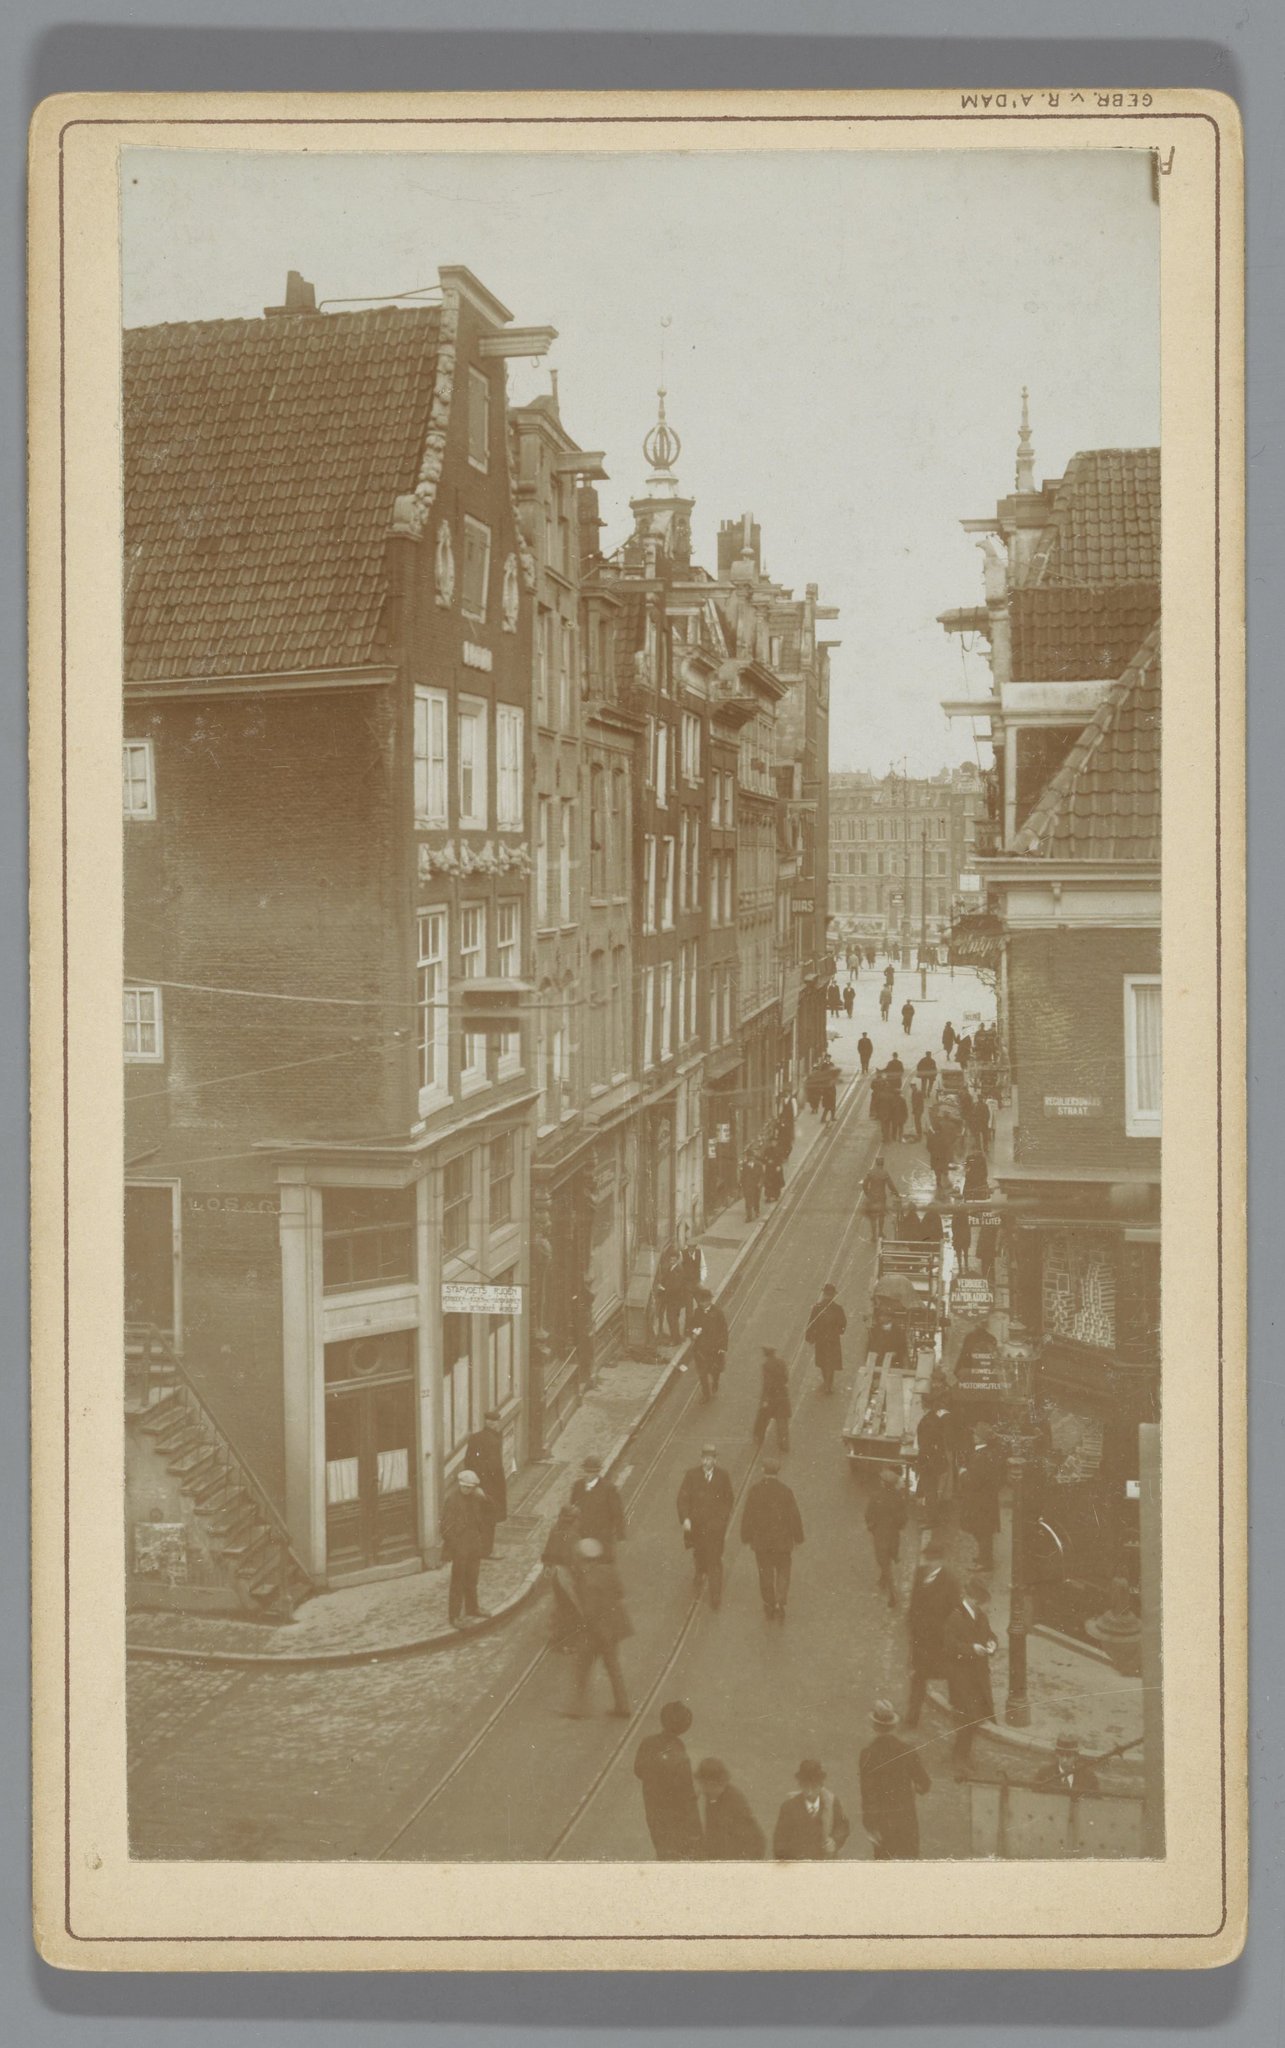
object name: cabinet photograph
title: Vijzelstraat te Amsterdam, voor de verbreding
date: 1900-1915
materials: paper, cardboard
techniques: collodion silver print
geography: amsterdam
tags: street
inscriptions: inscription: ‘Oude Huizen in de/ Vijzelstraat, ziende van/ de Reguliersdwarsstraat/ naar het Singel./ Allen afgebroken ter/ verbreeding van de Vijzel-/ straat’, collector's mark: ‘Vosmaer’